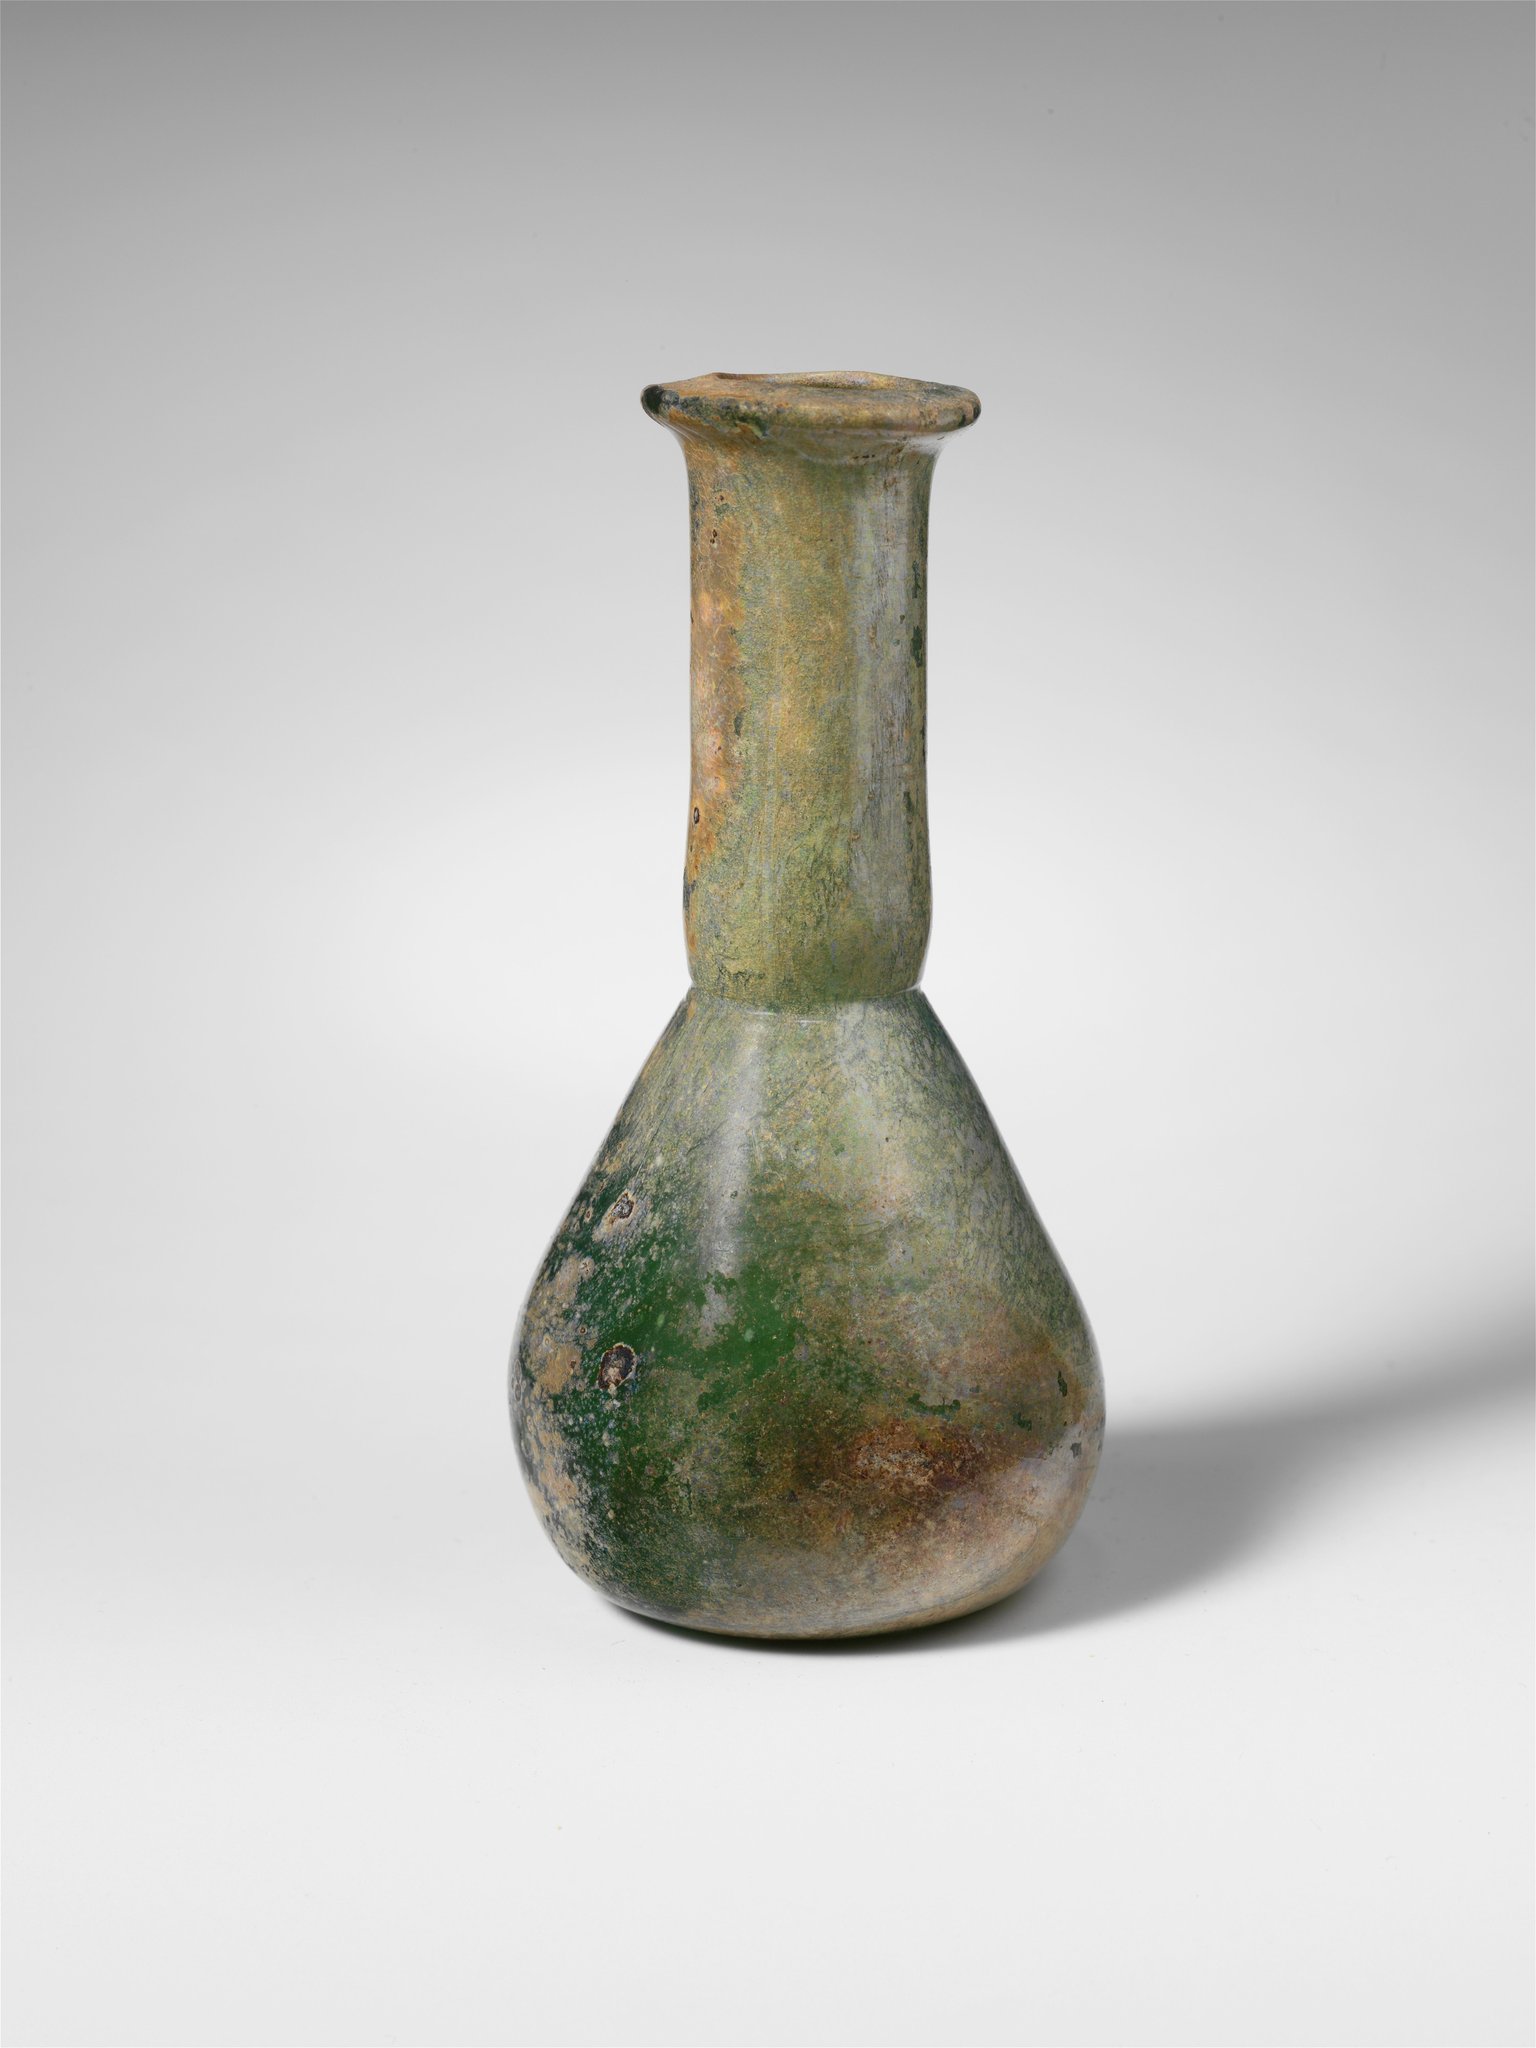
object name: perfume bottle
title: Glass perfume bottle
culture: roman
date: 1-100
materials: glass